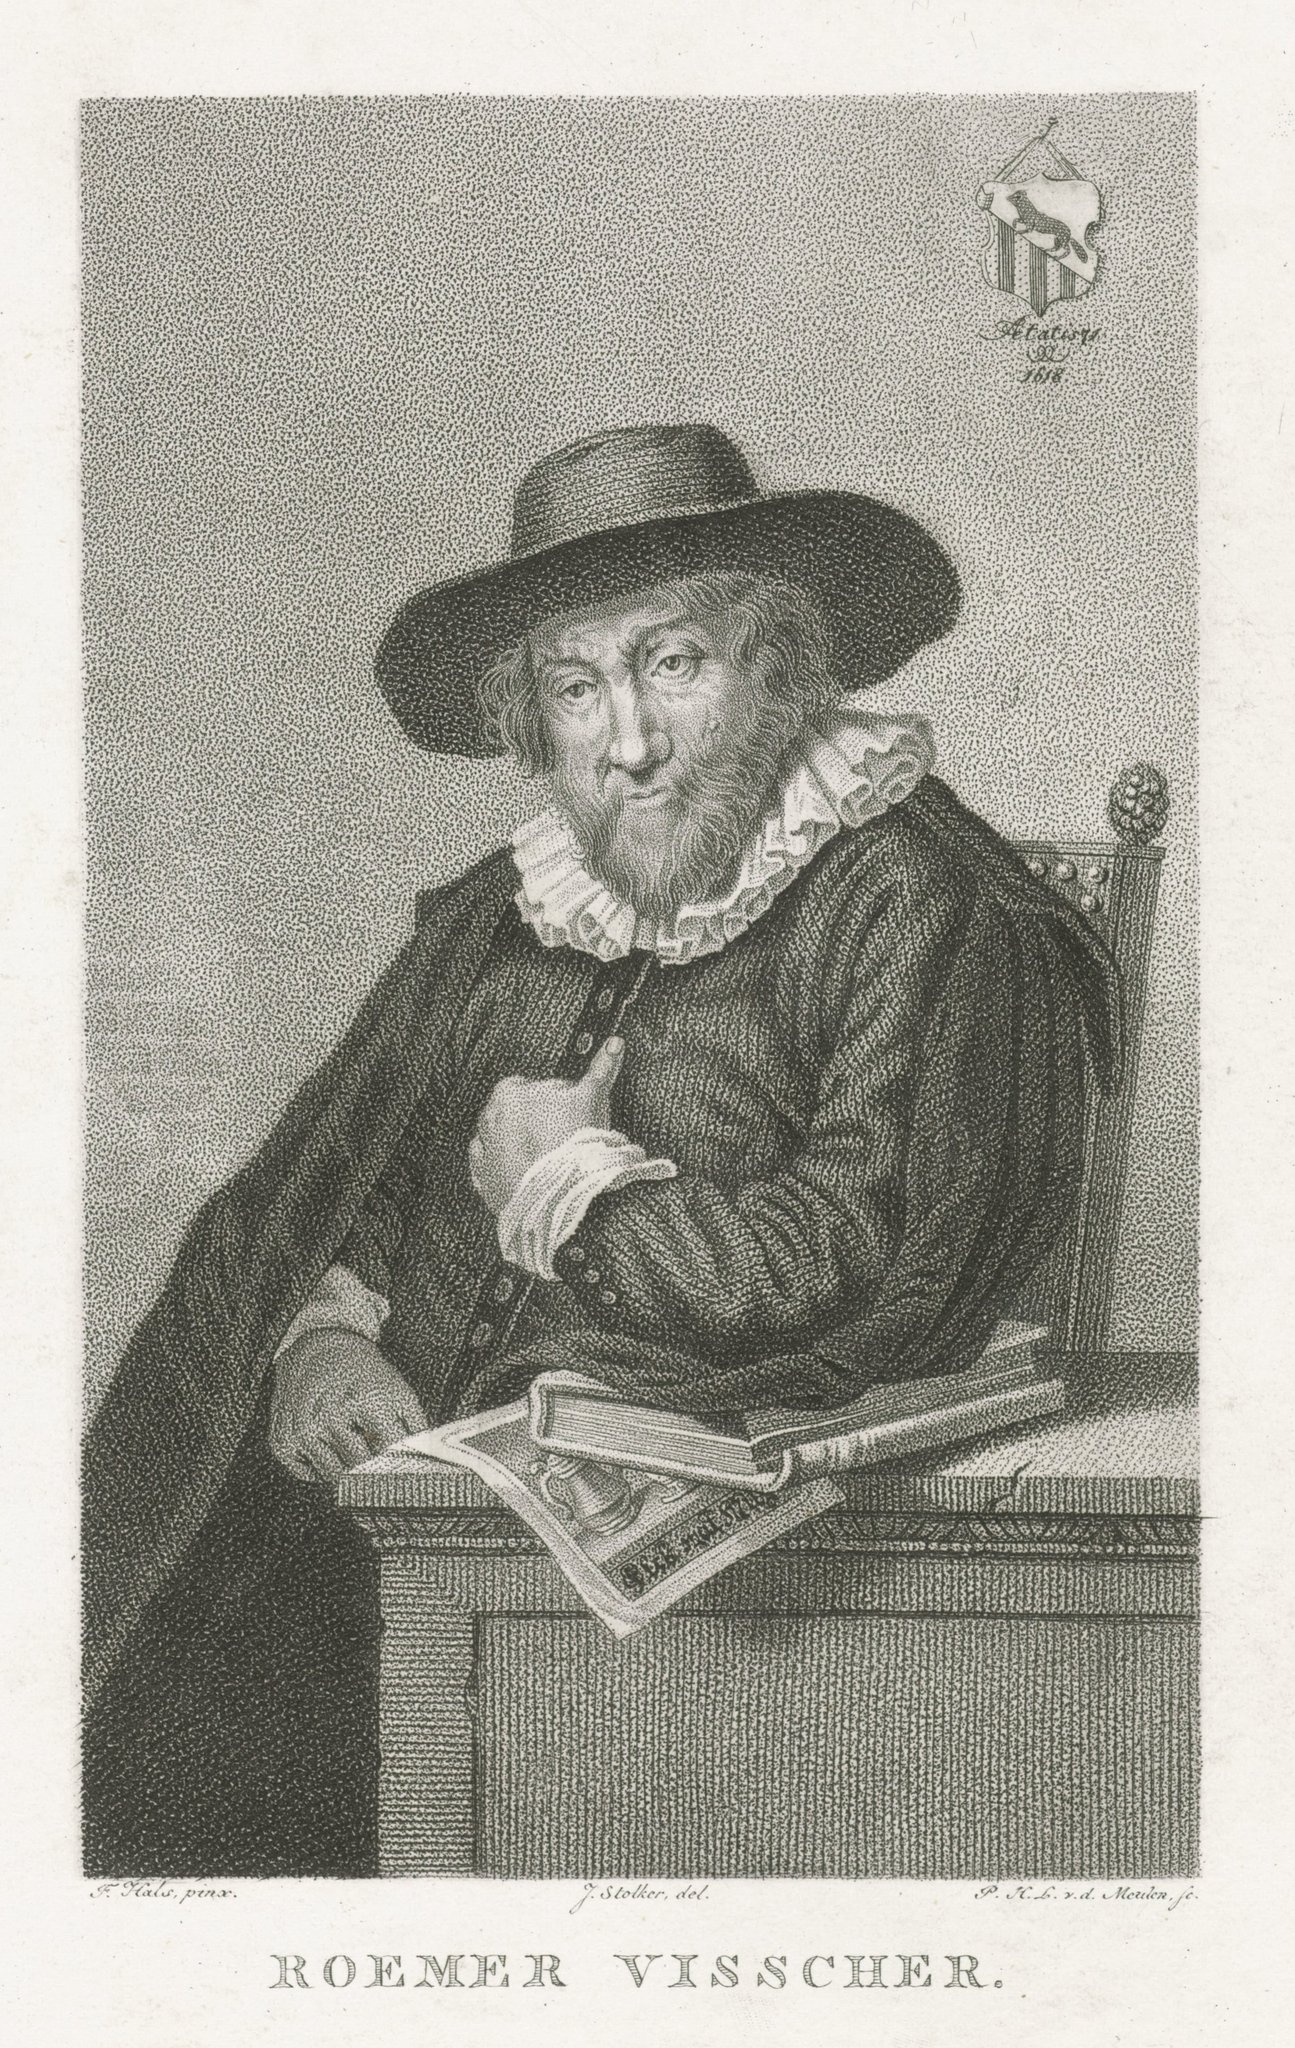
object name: print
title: Portret van Roemer Visscher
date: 1790-1858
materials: paper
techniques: stippled etching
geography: amsterdam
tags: roemer visscher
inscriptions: collector's mark: Lugt 2228, collector's mark: Lugt 963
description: Portret van koopman en dichter Roemer Visscher op 71-jarige leeftijd, zittend bij een tafel.